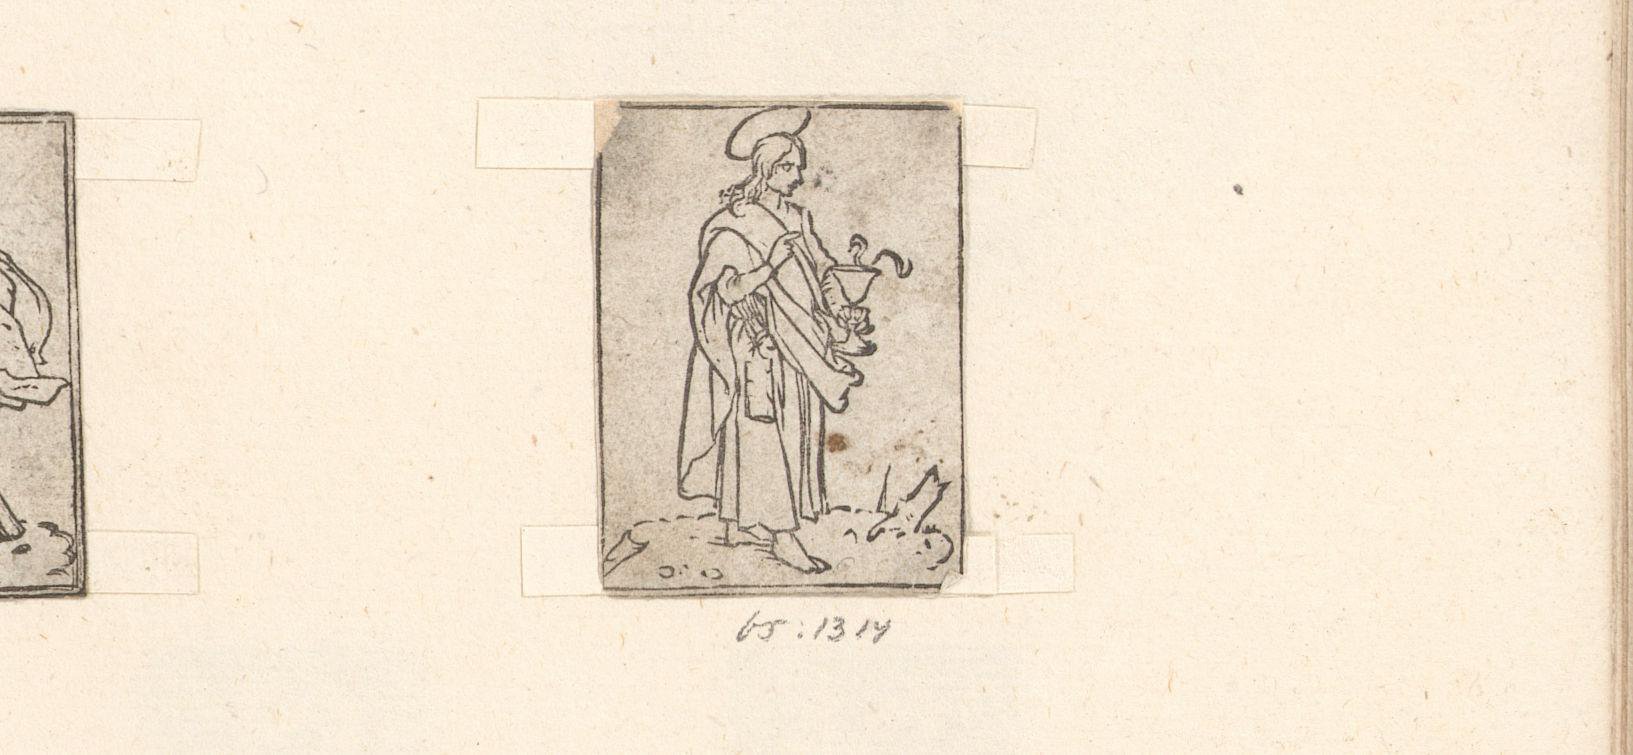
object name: book illustration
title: Apostelen, aartsengelen en heiligen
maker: hans holbein (der jüngere)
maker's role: draughtsman, painter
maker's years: 1497-1543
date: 1507-1543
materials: paper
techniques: woodcut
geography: switzerland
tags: the apostle john the evangelist; possible attributes: book, cauldron, chalice with snake, eagle, palm, scroll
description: Johannes de Evangelist met kelk en slang. Prent maakt deel uit van een album.